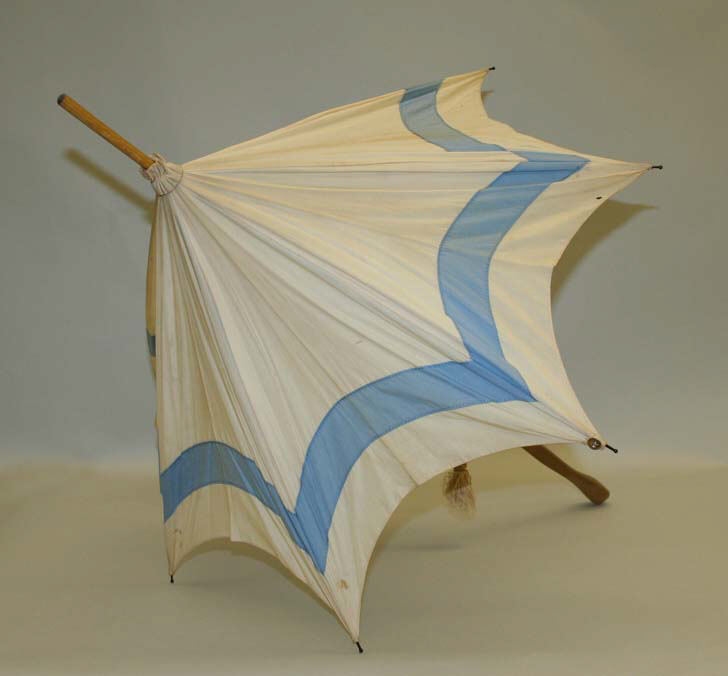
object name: parasol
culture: american or european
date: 1900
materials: metal, silk, wood